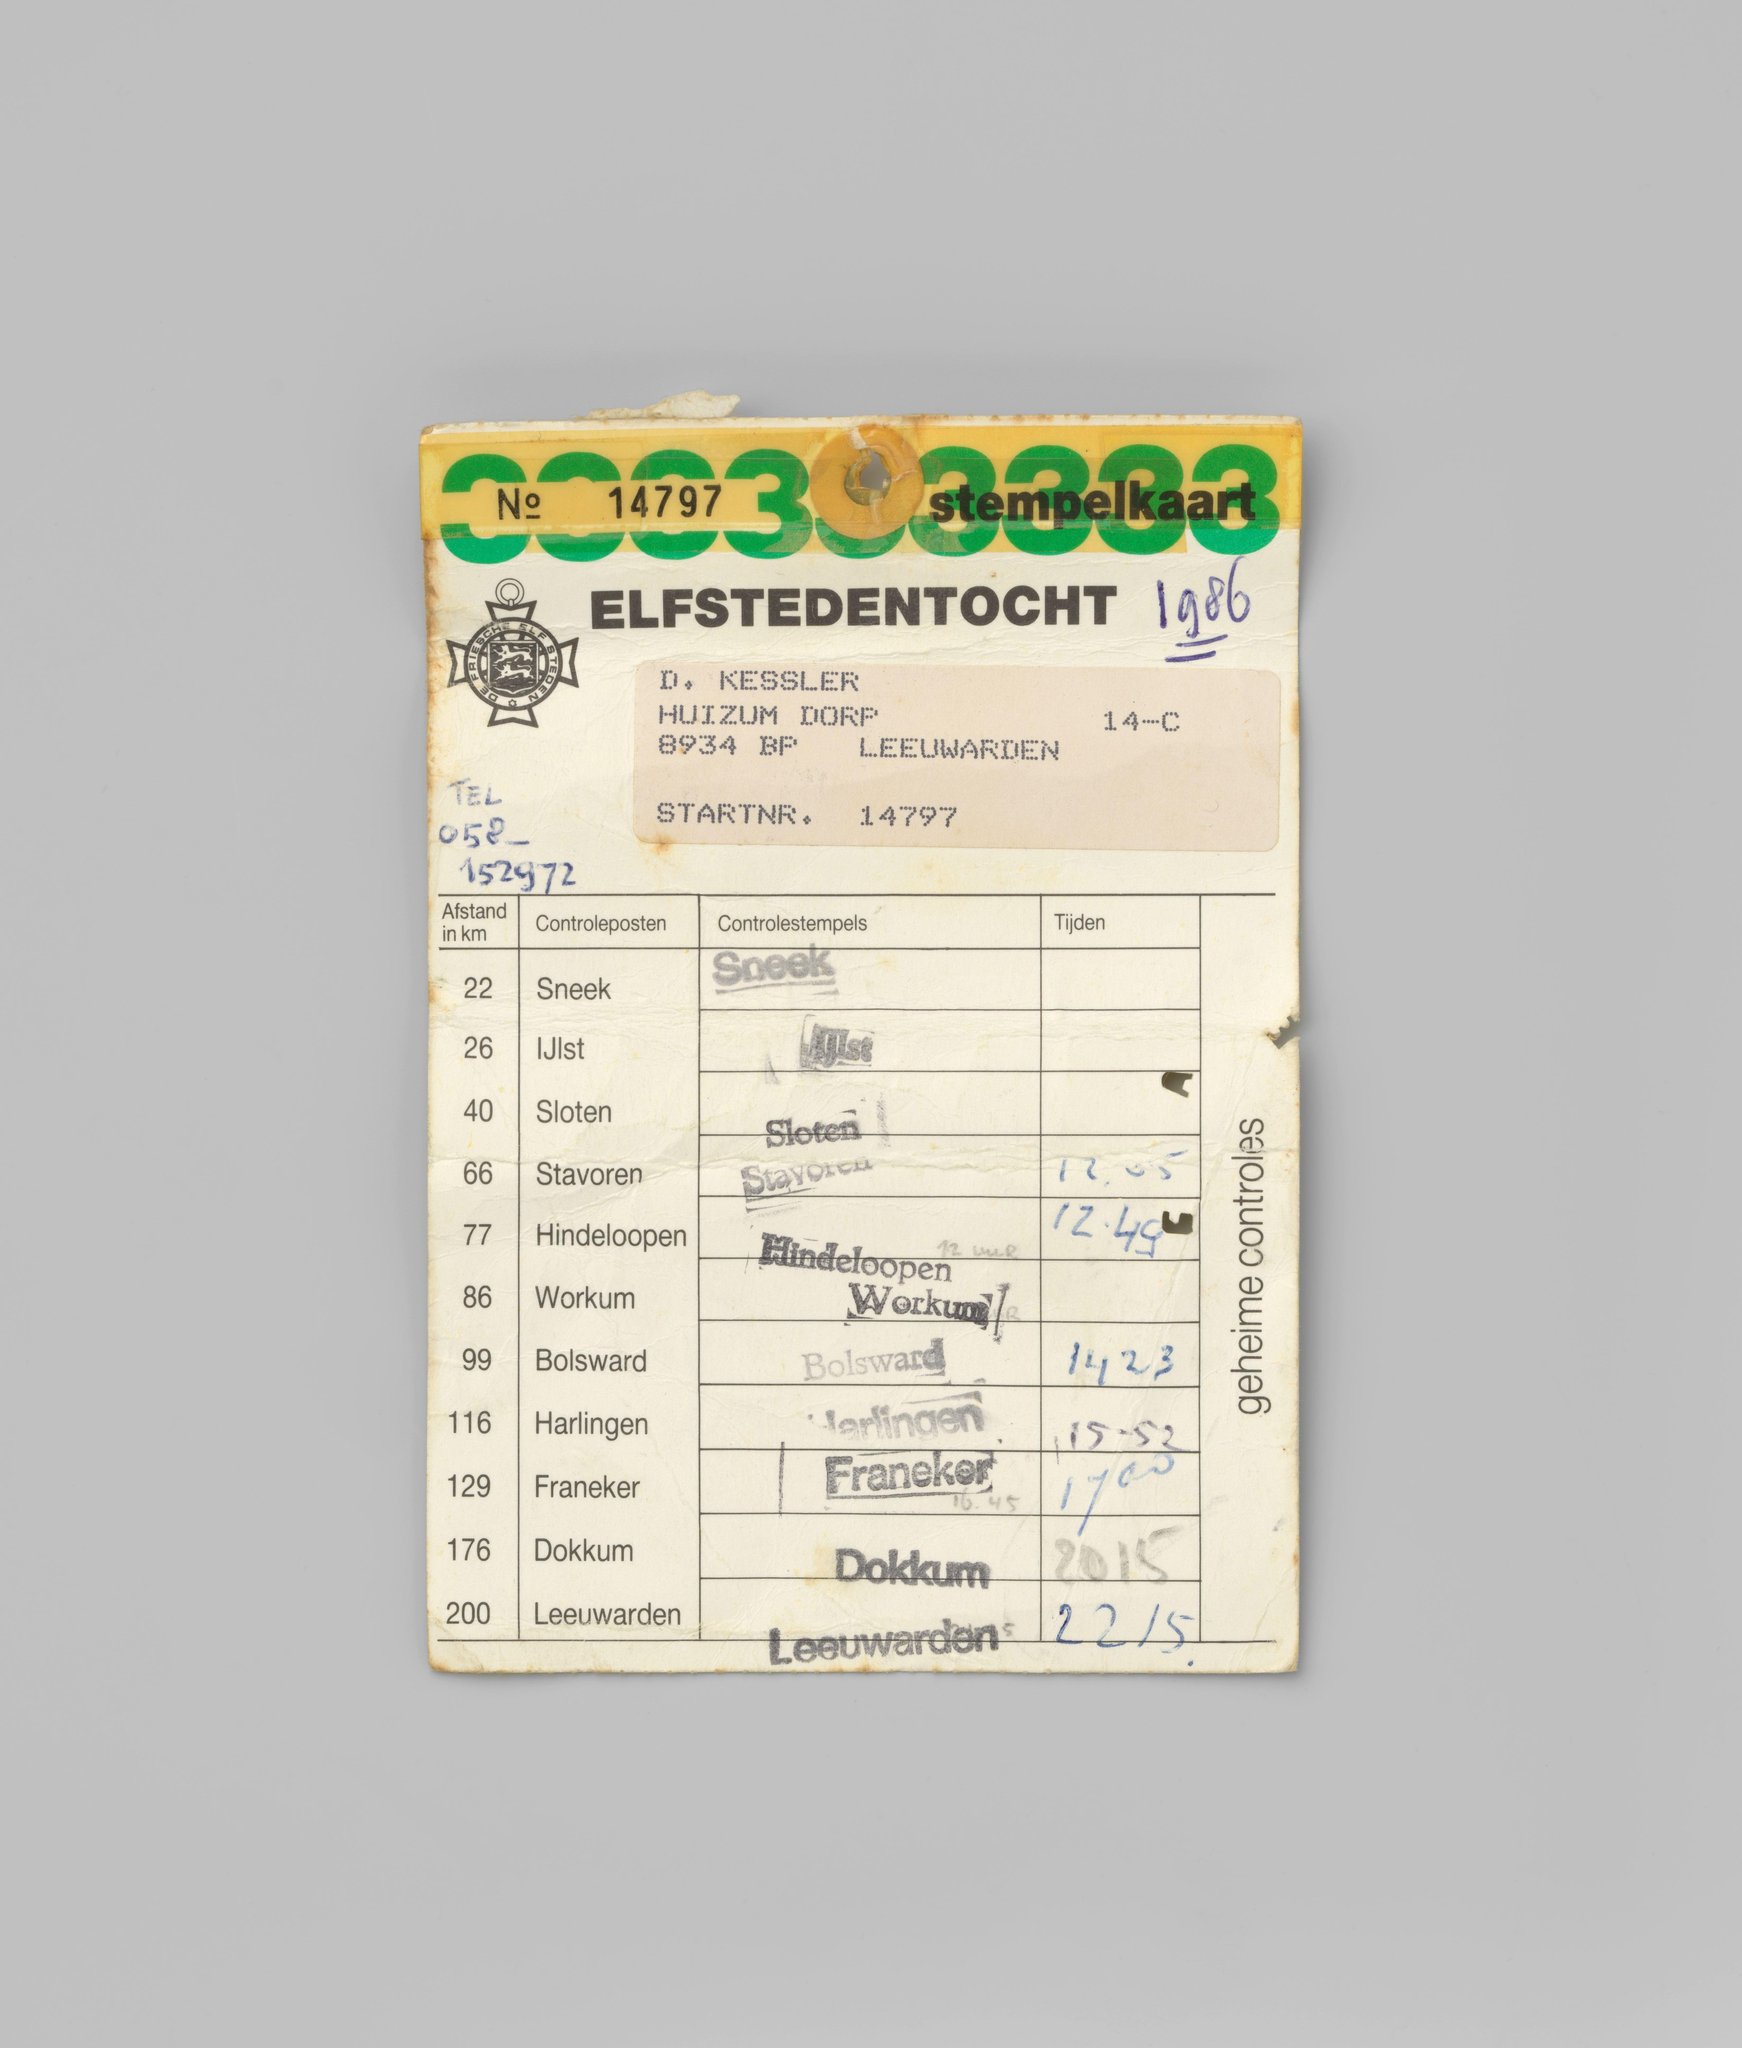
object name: map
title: Stempelkaart Elfstedentocht 1986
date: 1986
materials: cardboard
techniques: printing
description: Rechthoekige kartonnen kaart, met aan de bovenzijde een gaatje. Aan de achterzijde geplastificeerd, op naam van D. Kessler, no. 14797. Met lijst van elf plaatsnamen, waarachter stempels en doorgangstijden. Aan de achterzijde een kaart van Friesland met de route van de Elfstedentocht.